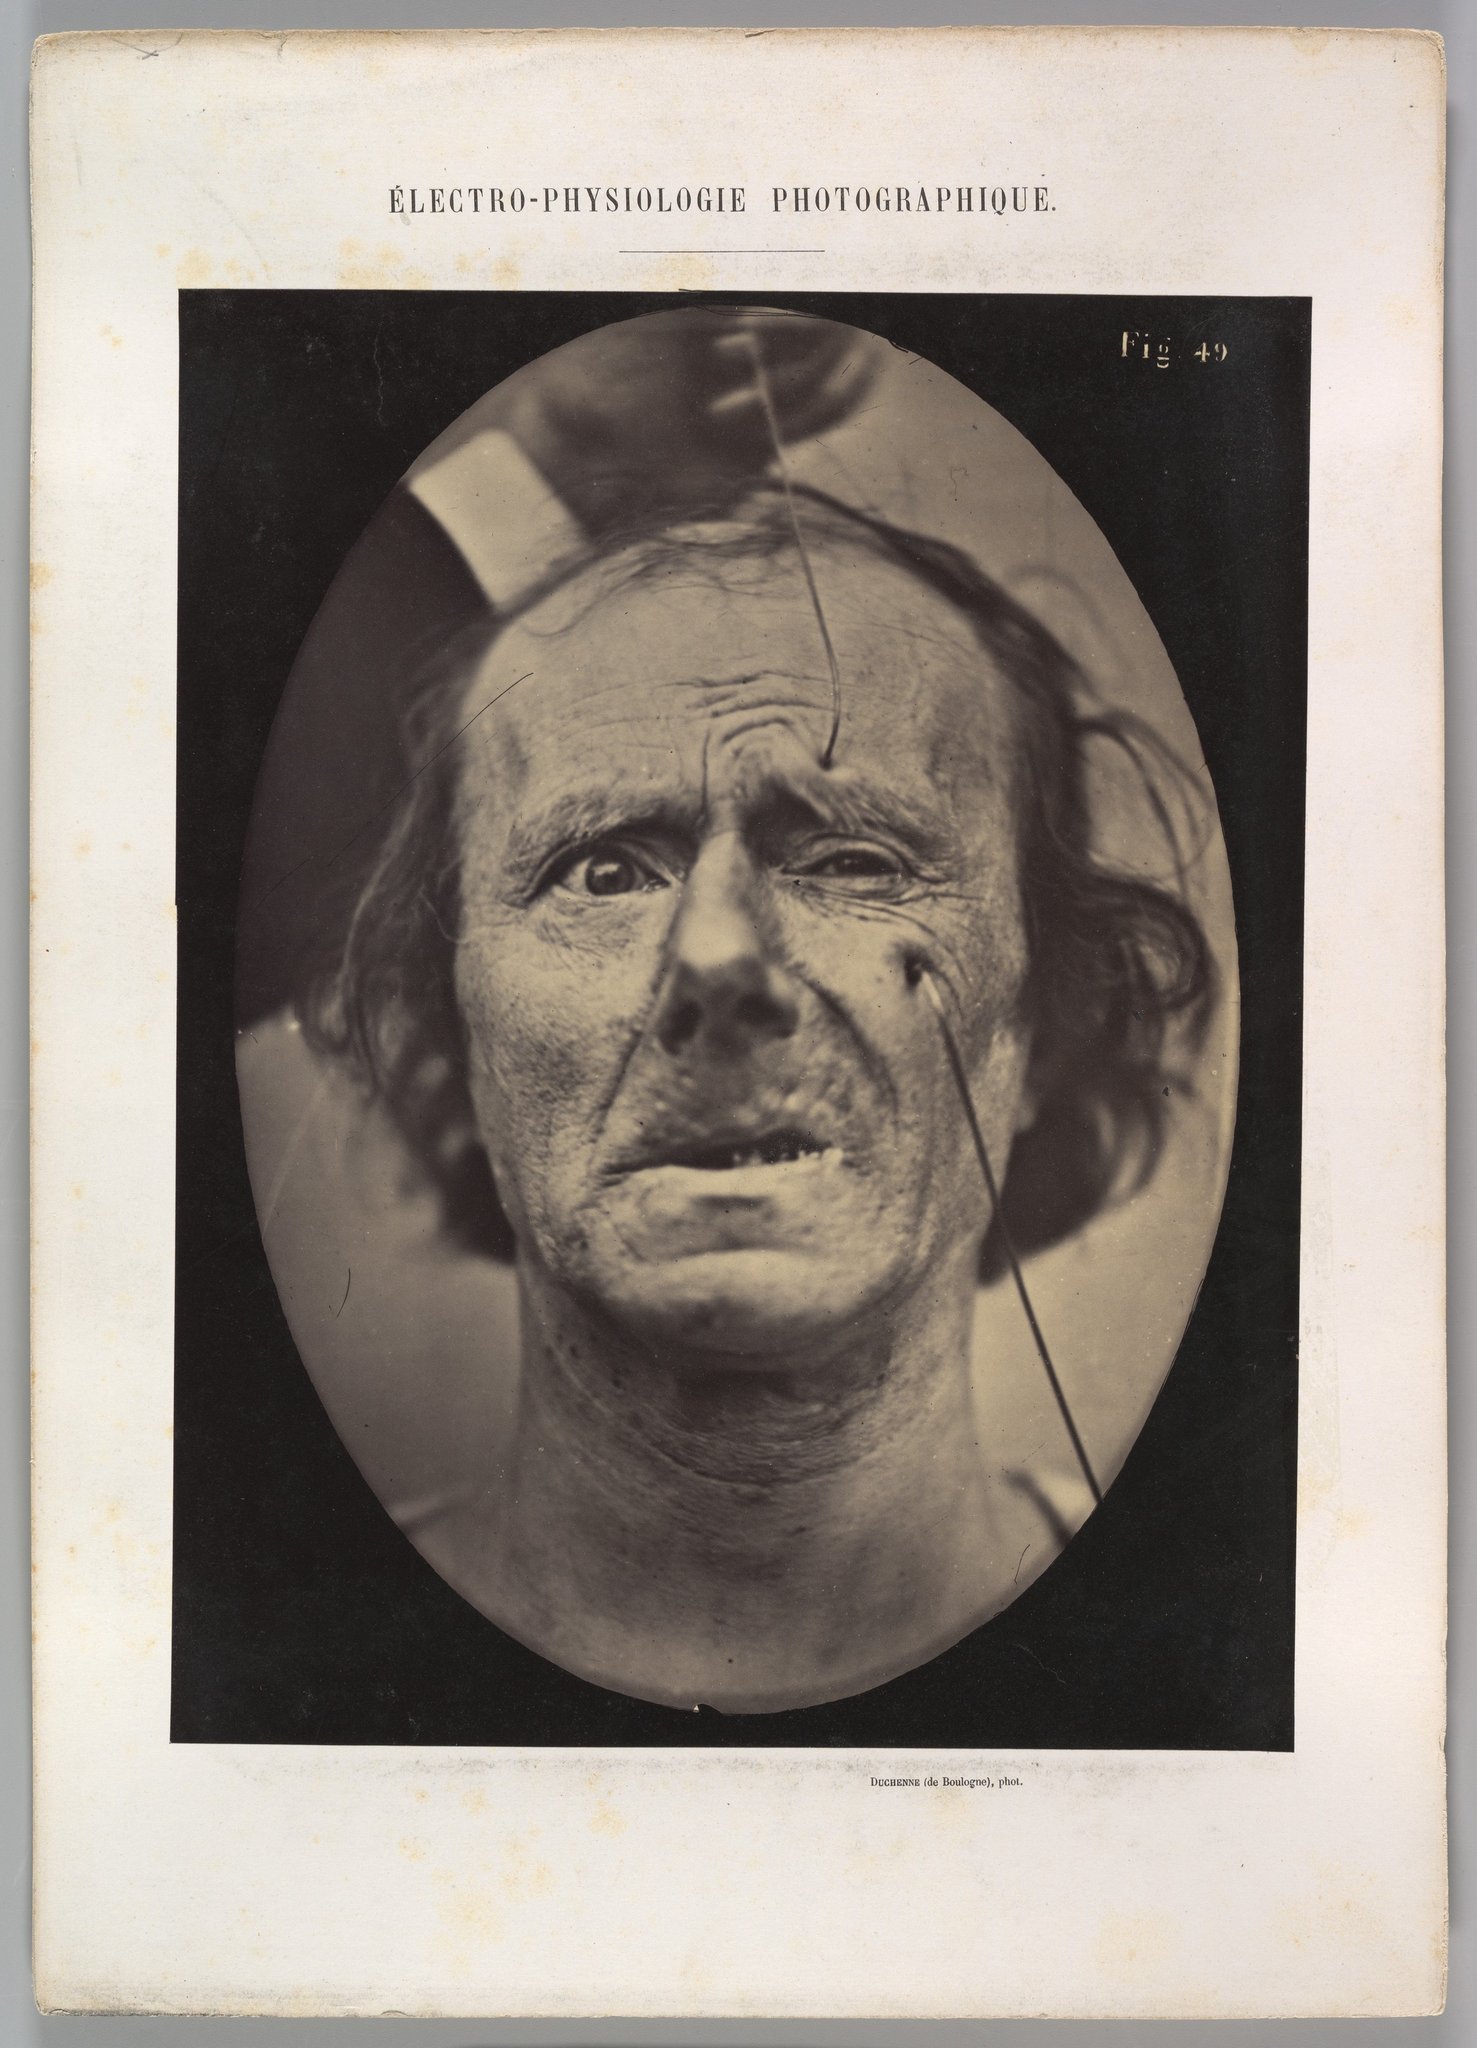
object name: photograph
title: Figure 49: Painful weeping and forward looking.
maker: guillaume-benjamin-amand duchenne de boulogne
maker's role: artist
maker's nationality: french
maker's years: 1806-1875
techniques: albumen silver print, glass negative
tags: science,men,portraits